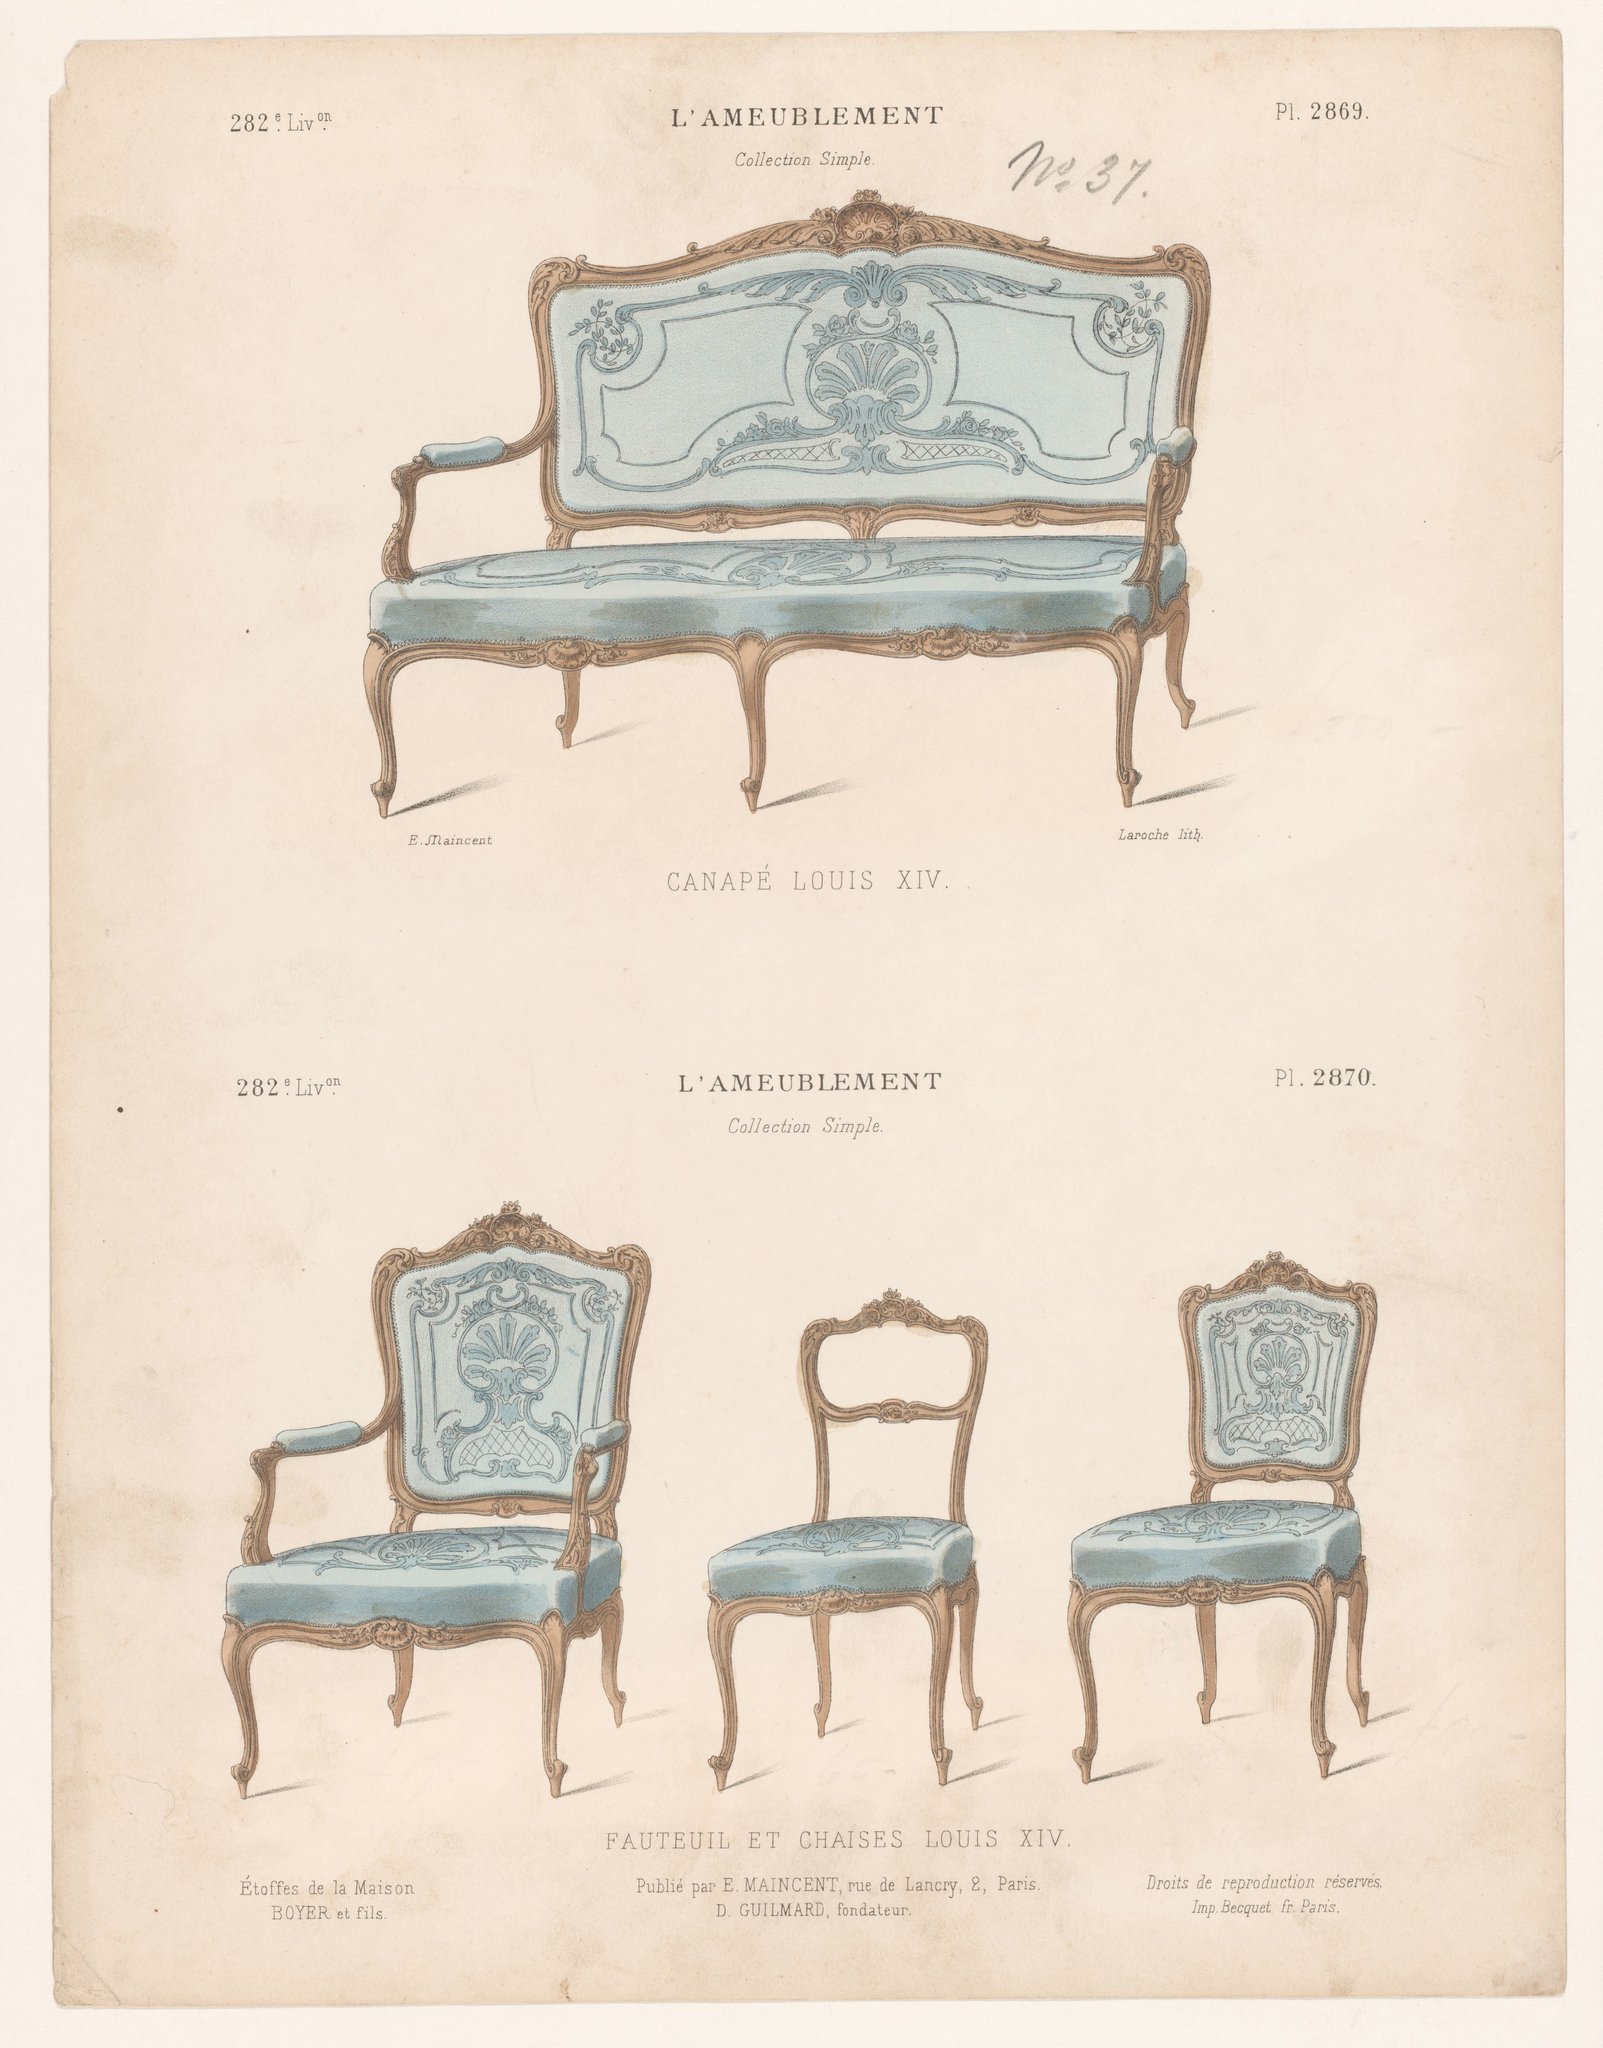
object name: print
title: L'ameublement / Collection simple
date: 1885-1895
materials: paper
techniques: hand coloring, lithograph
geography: paris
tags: seating furniture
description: Een canapé, een fauteuil en twee stoelen in de Lodewijk XIV-stijl. Prent uit 282e Livraison.